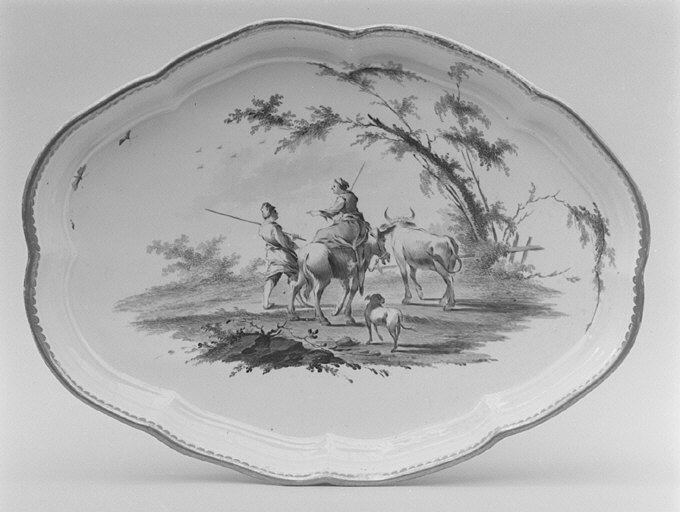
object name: tray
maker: gotha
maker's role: factory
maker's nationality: german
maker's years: 1757-1900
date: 1770-1780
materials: hard paste porcelain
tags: men,cows,dogs,donkeys,trees